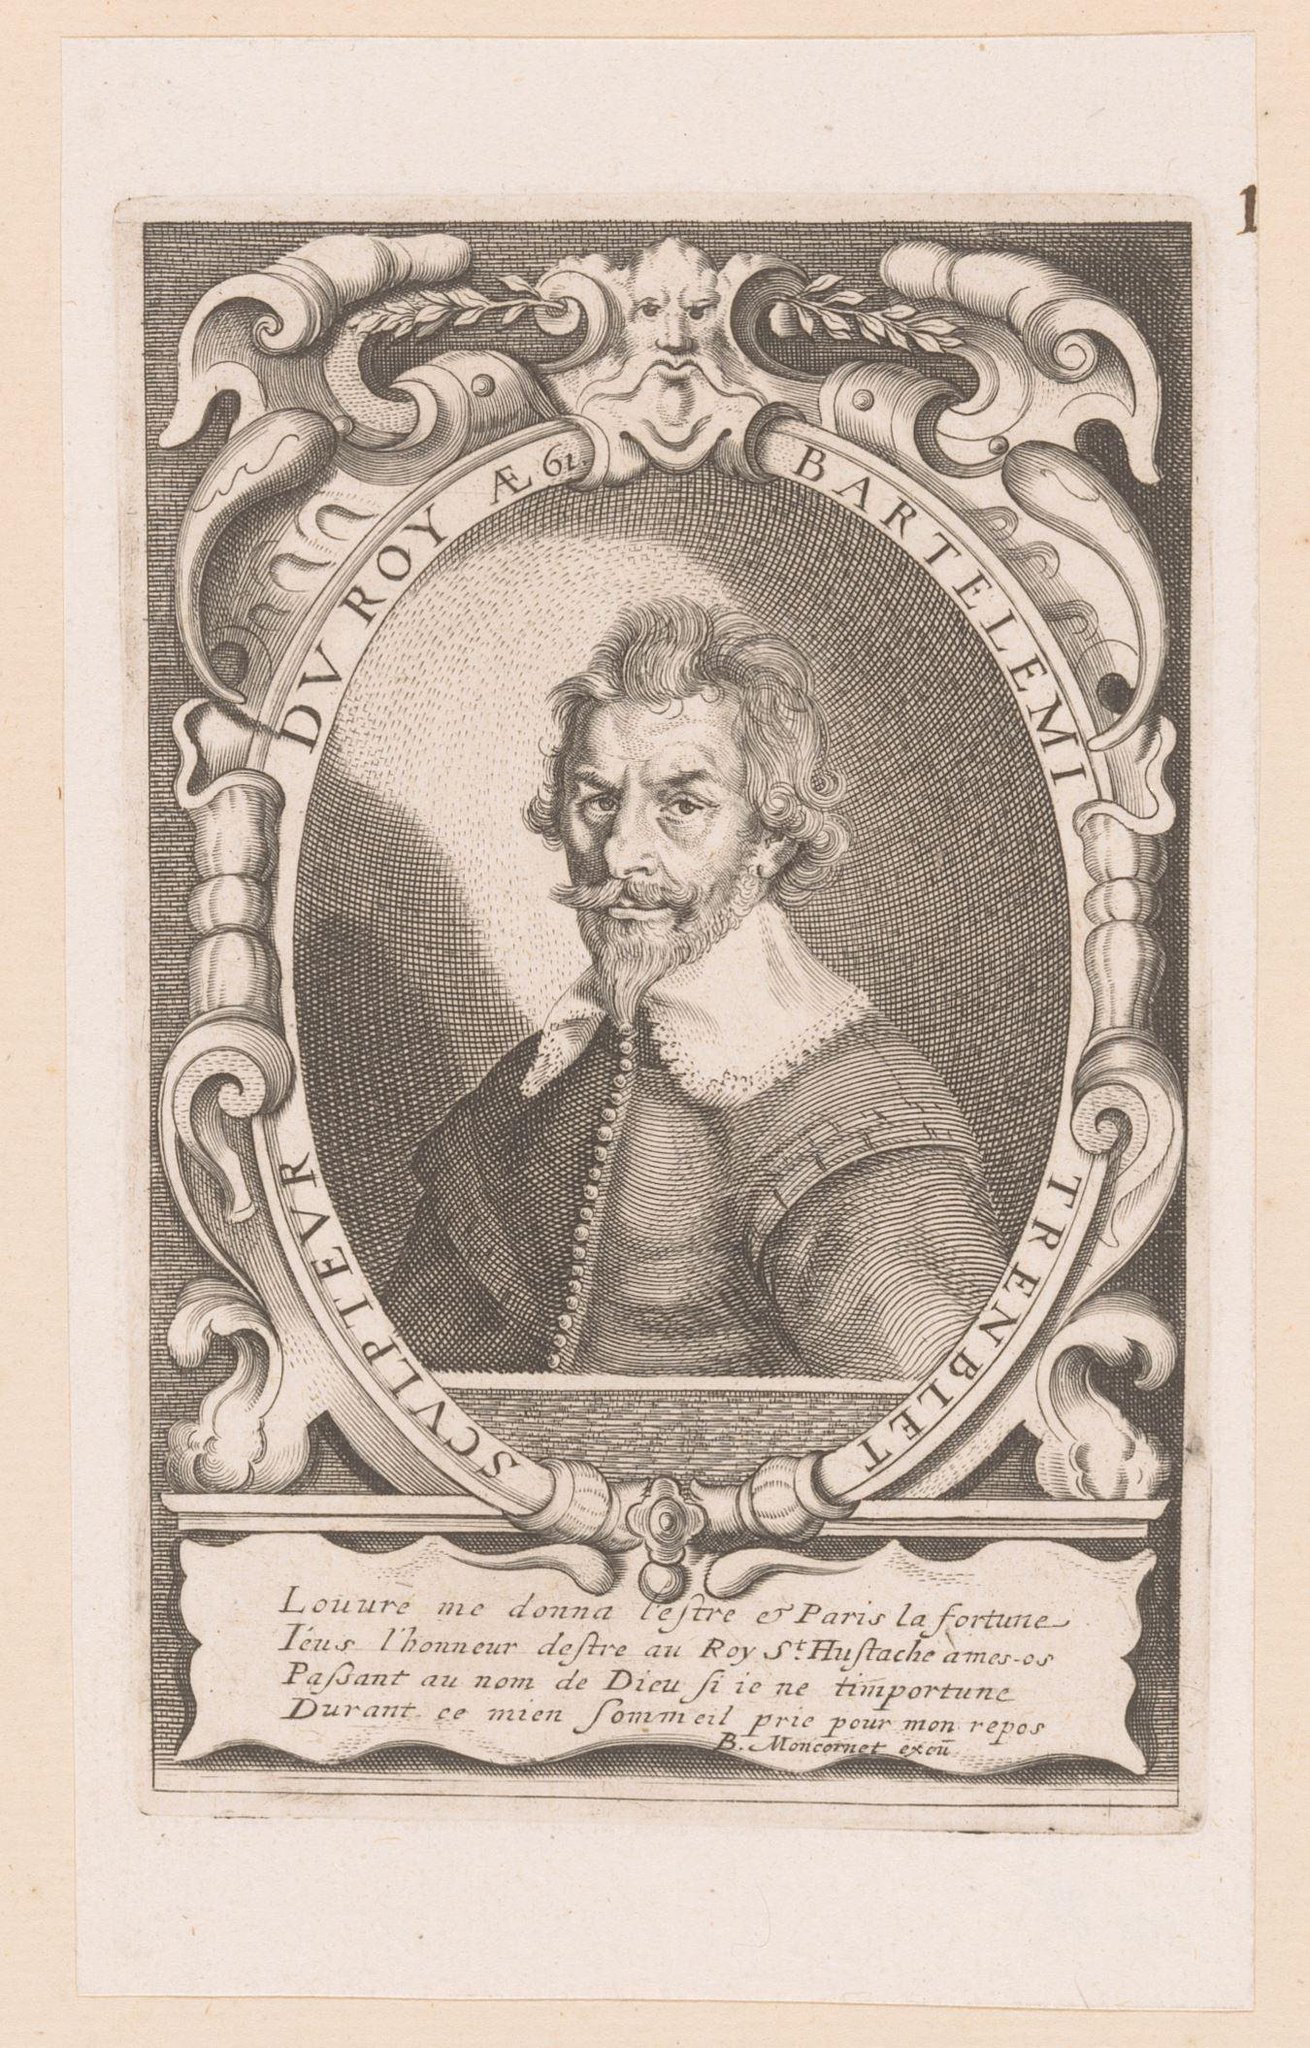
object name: print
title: Portret van Jacob Ernst Marcus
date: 1798-1826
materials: paper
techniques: aquatint, etching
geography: netherlands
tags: amsterdam, jacob ernst marcus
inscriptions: collector's mark: Lugt 2228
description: Portretbuste van Jacob Ernst Marcus met hoed en mantel.